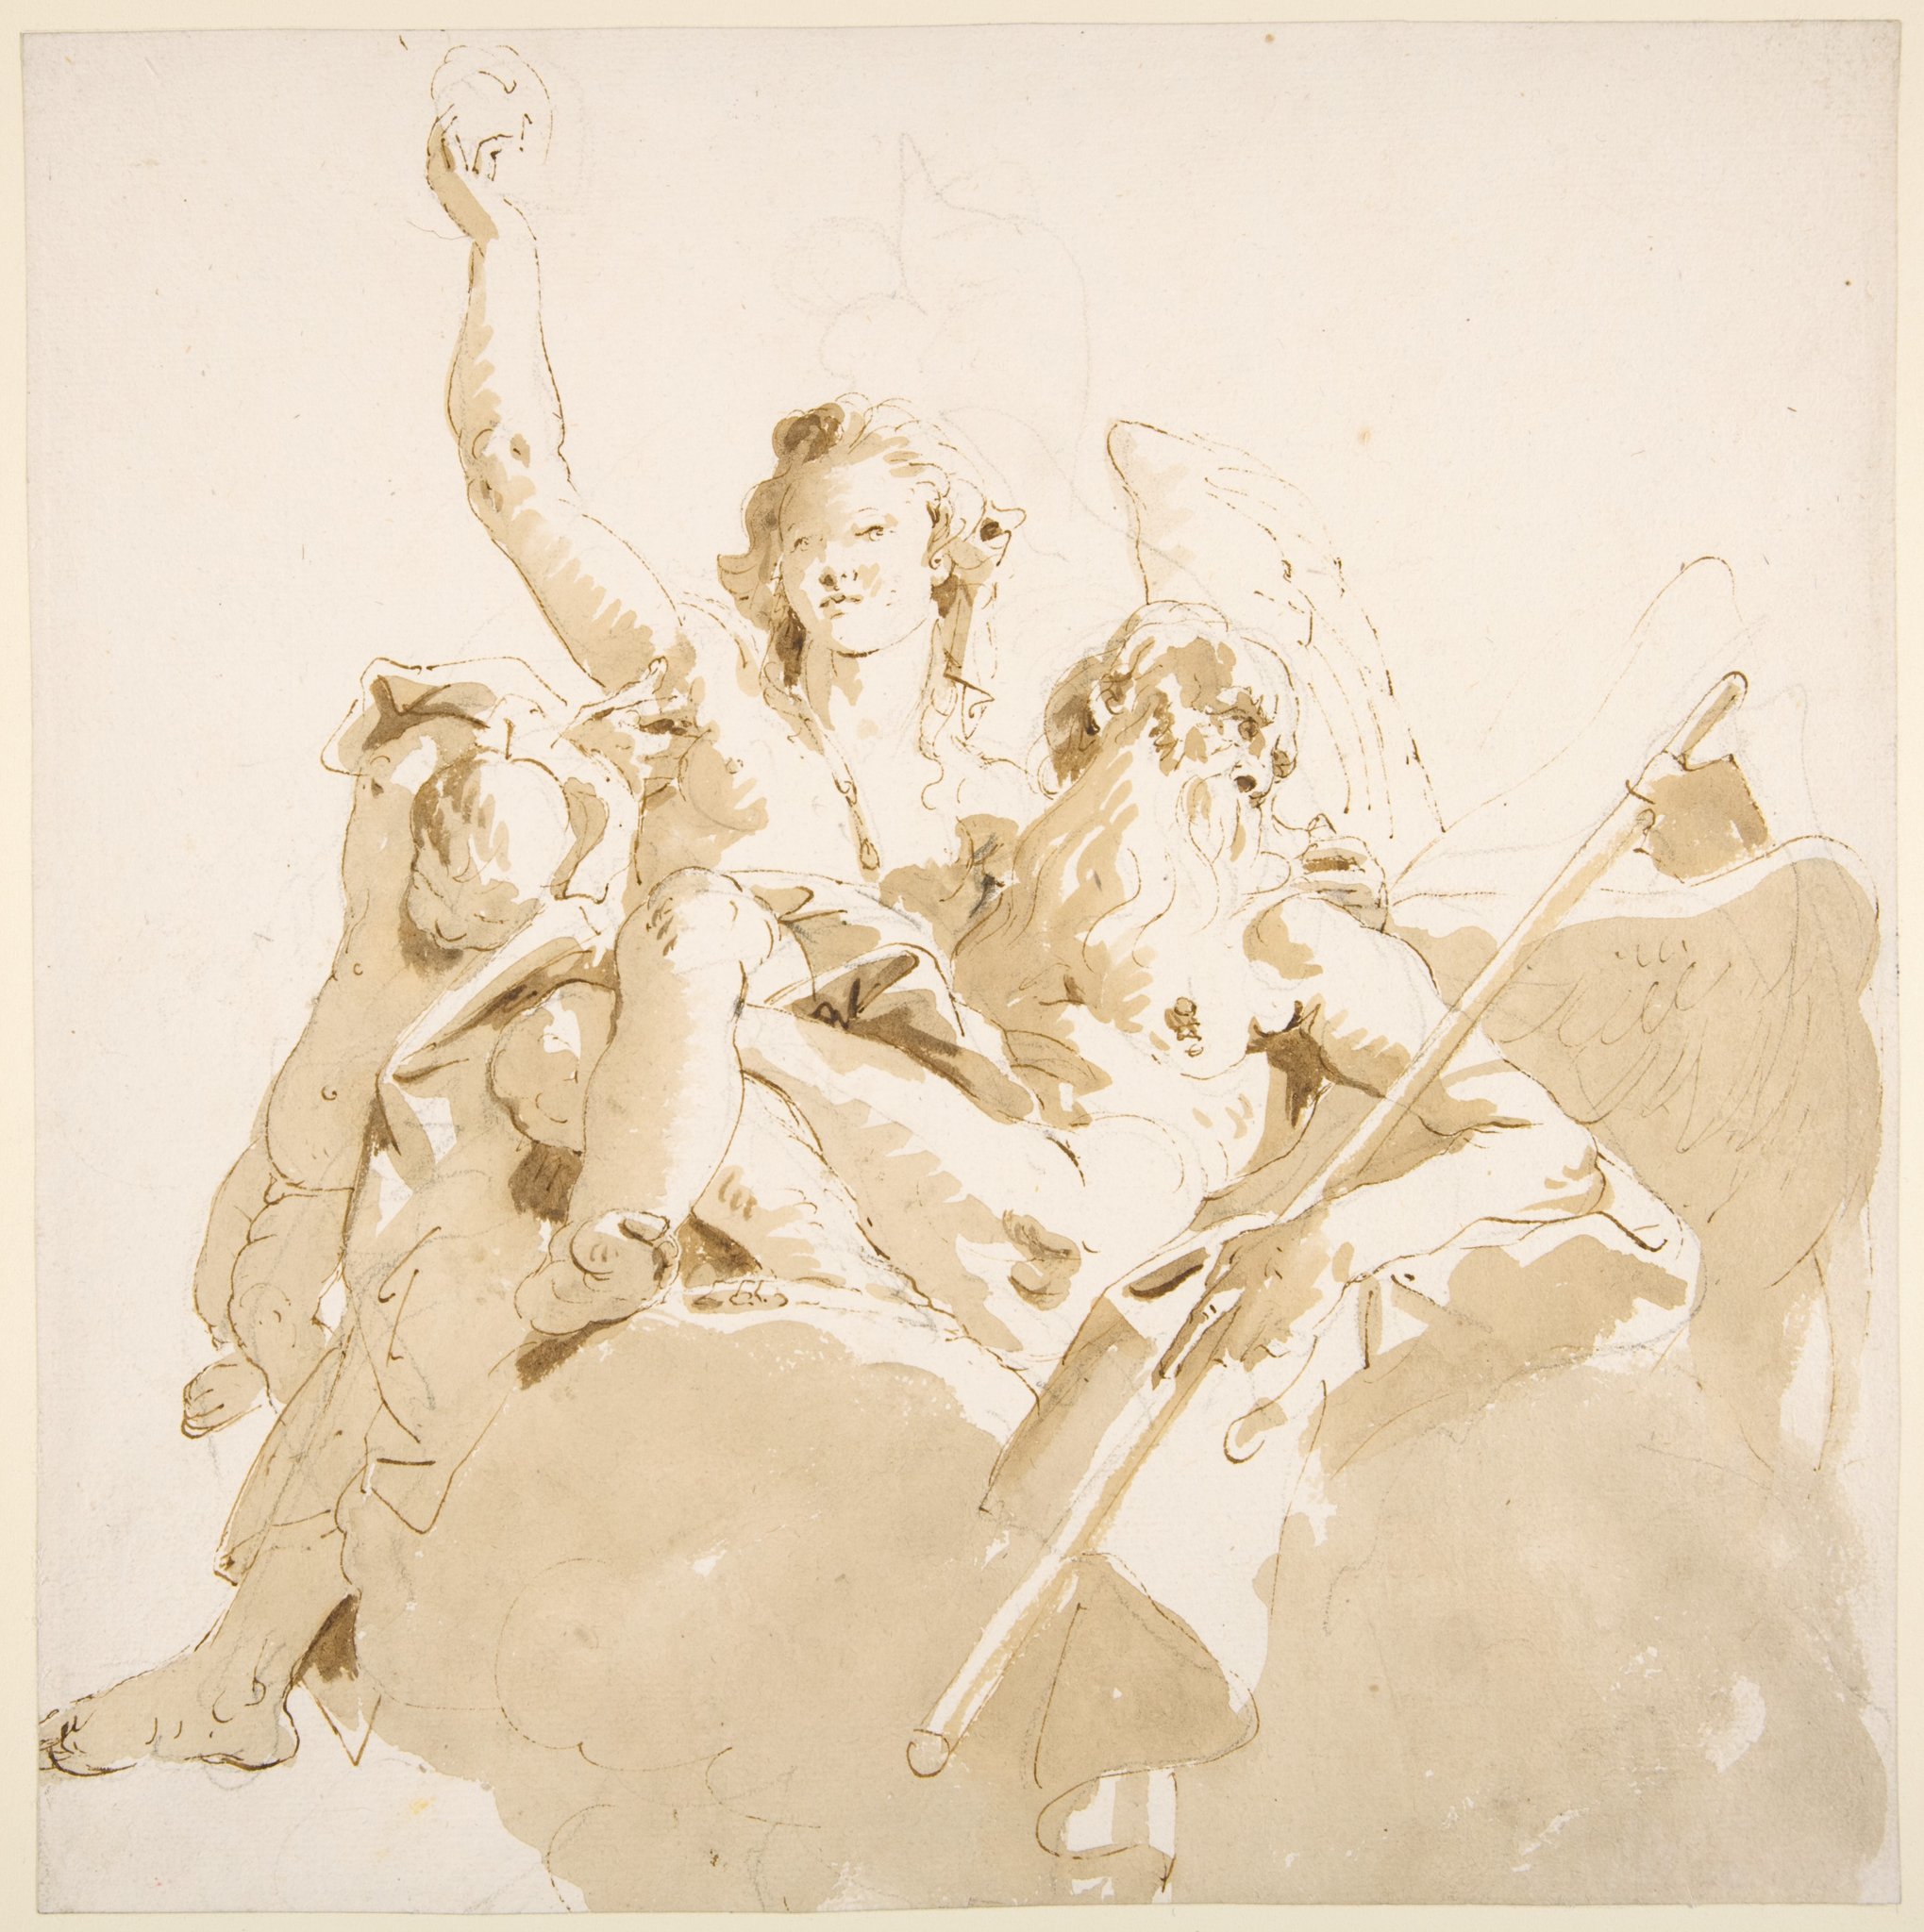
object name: drawing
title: Time and Truth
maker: giovanni battista tiepolo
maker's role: artist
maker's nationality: italian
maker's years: 1696-1770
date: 1696-1770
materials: chalk, ink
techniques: brush, pen, wash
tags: weapons,women